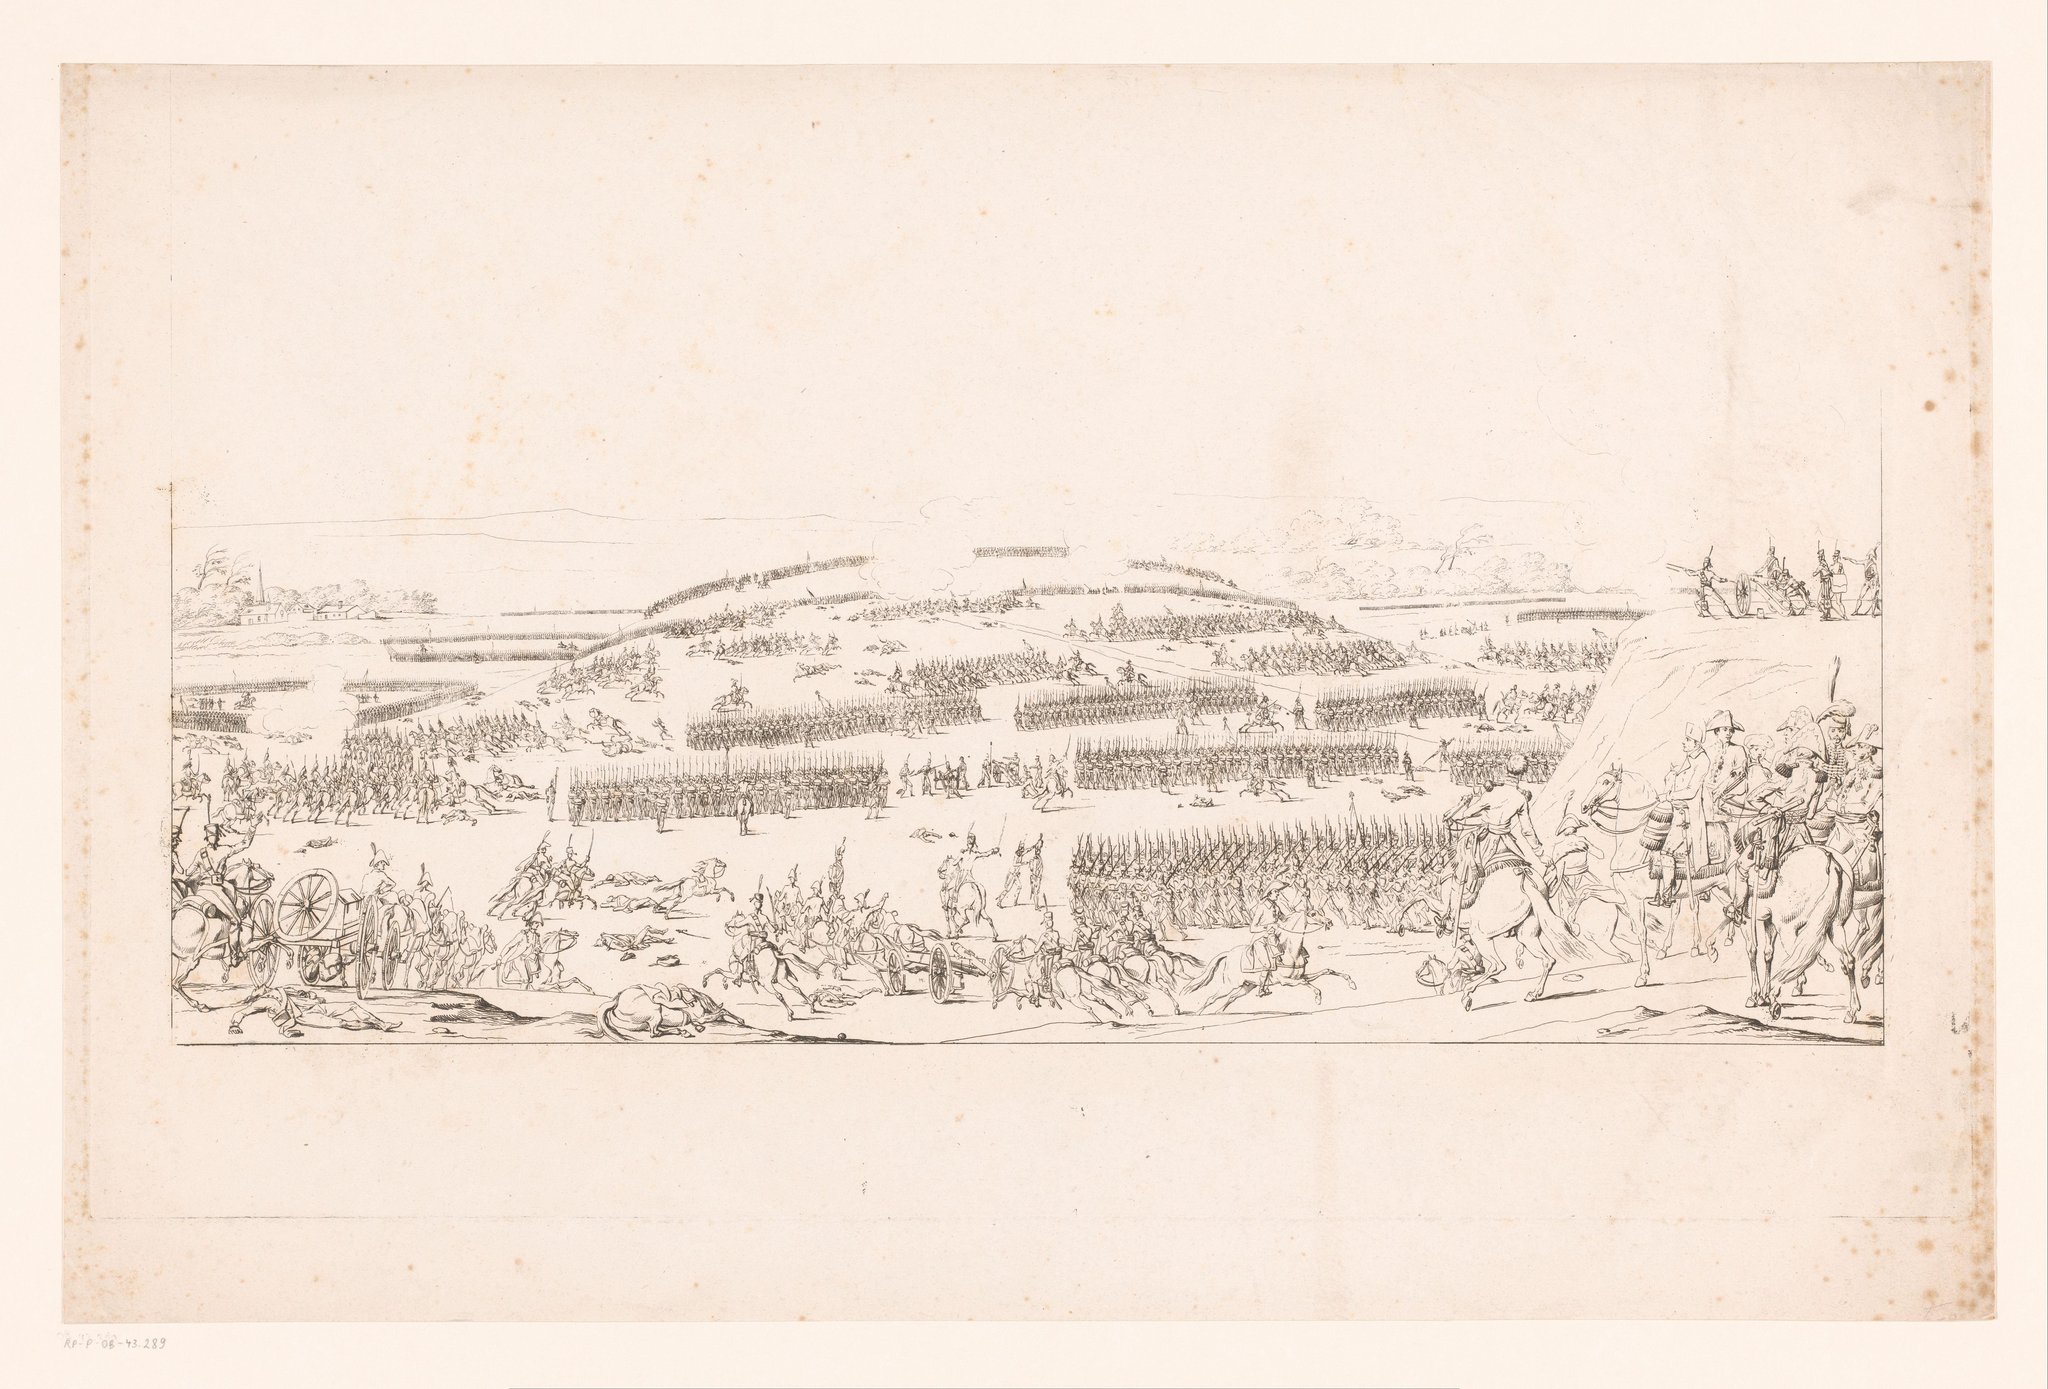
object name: print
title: Landschap met slagveld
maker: jean duplessis-bertaux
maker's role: print maker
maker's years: 1750-1818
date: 1760-1818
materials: paper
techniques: etching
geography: france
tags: landscapes, battle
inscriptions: collector's mark: Lugt 2228